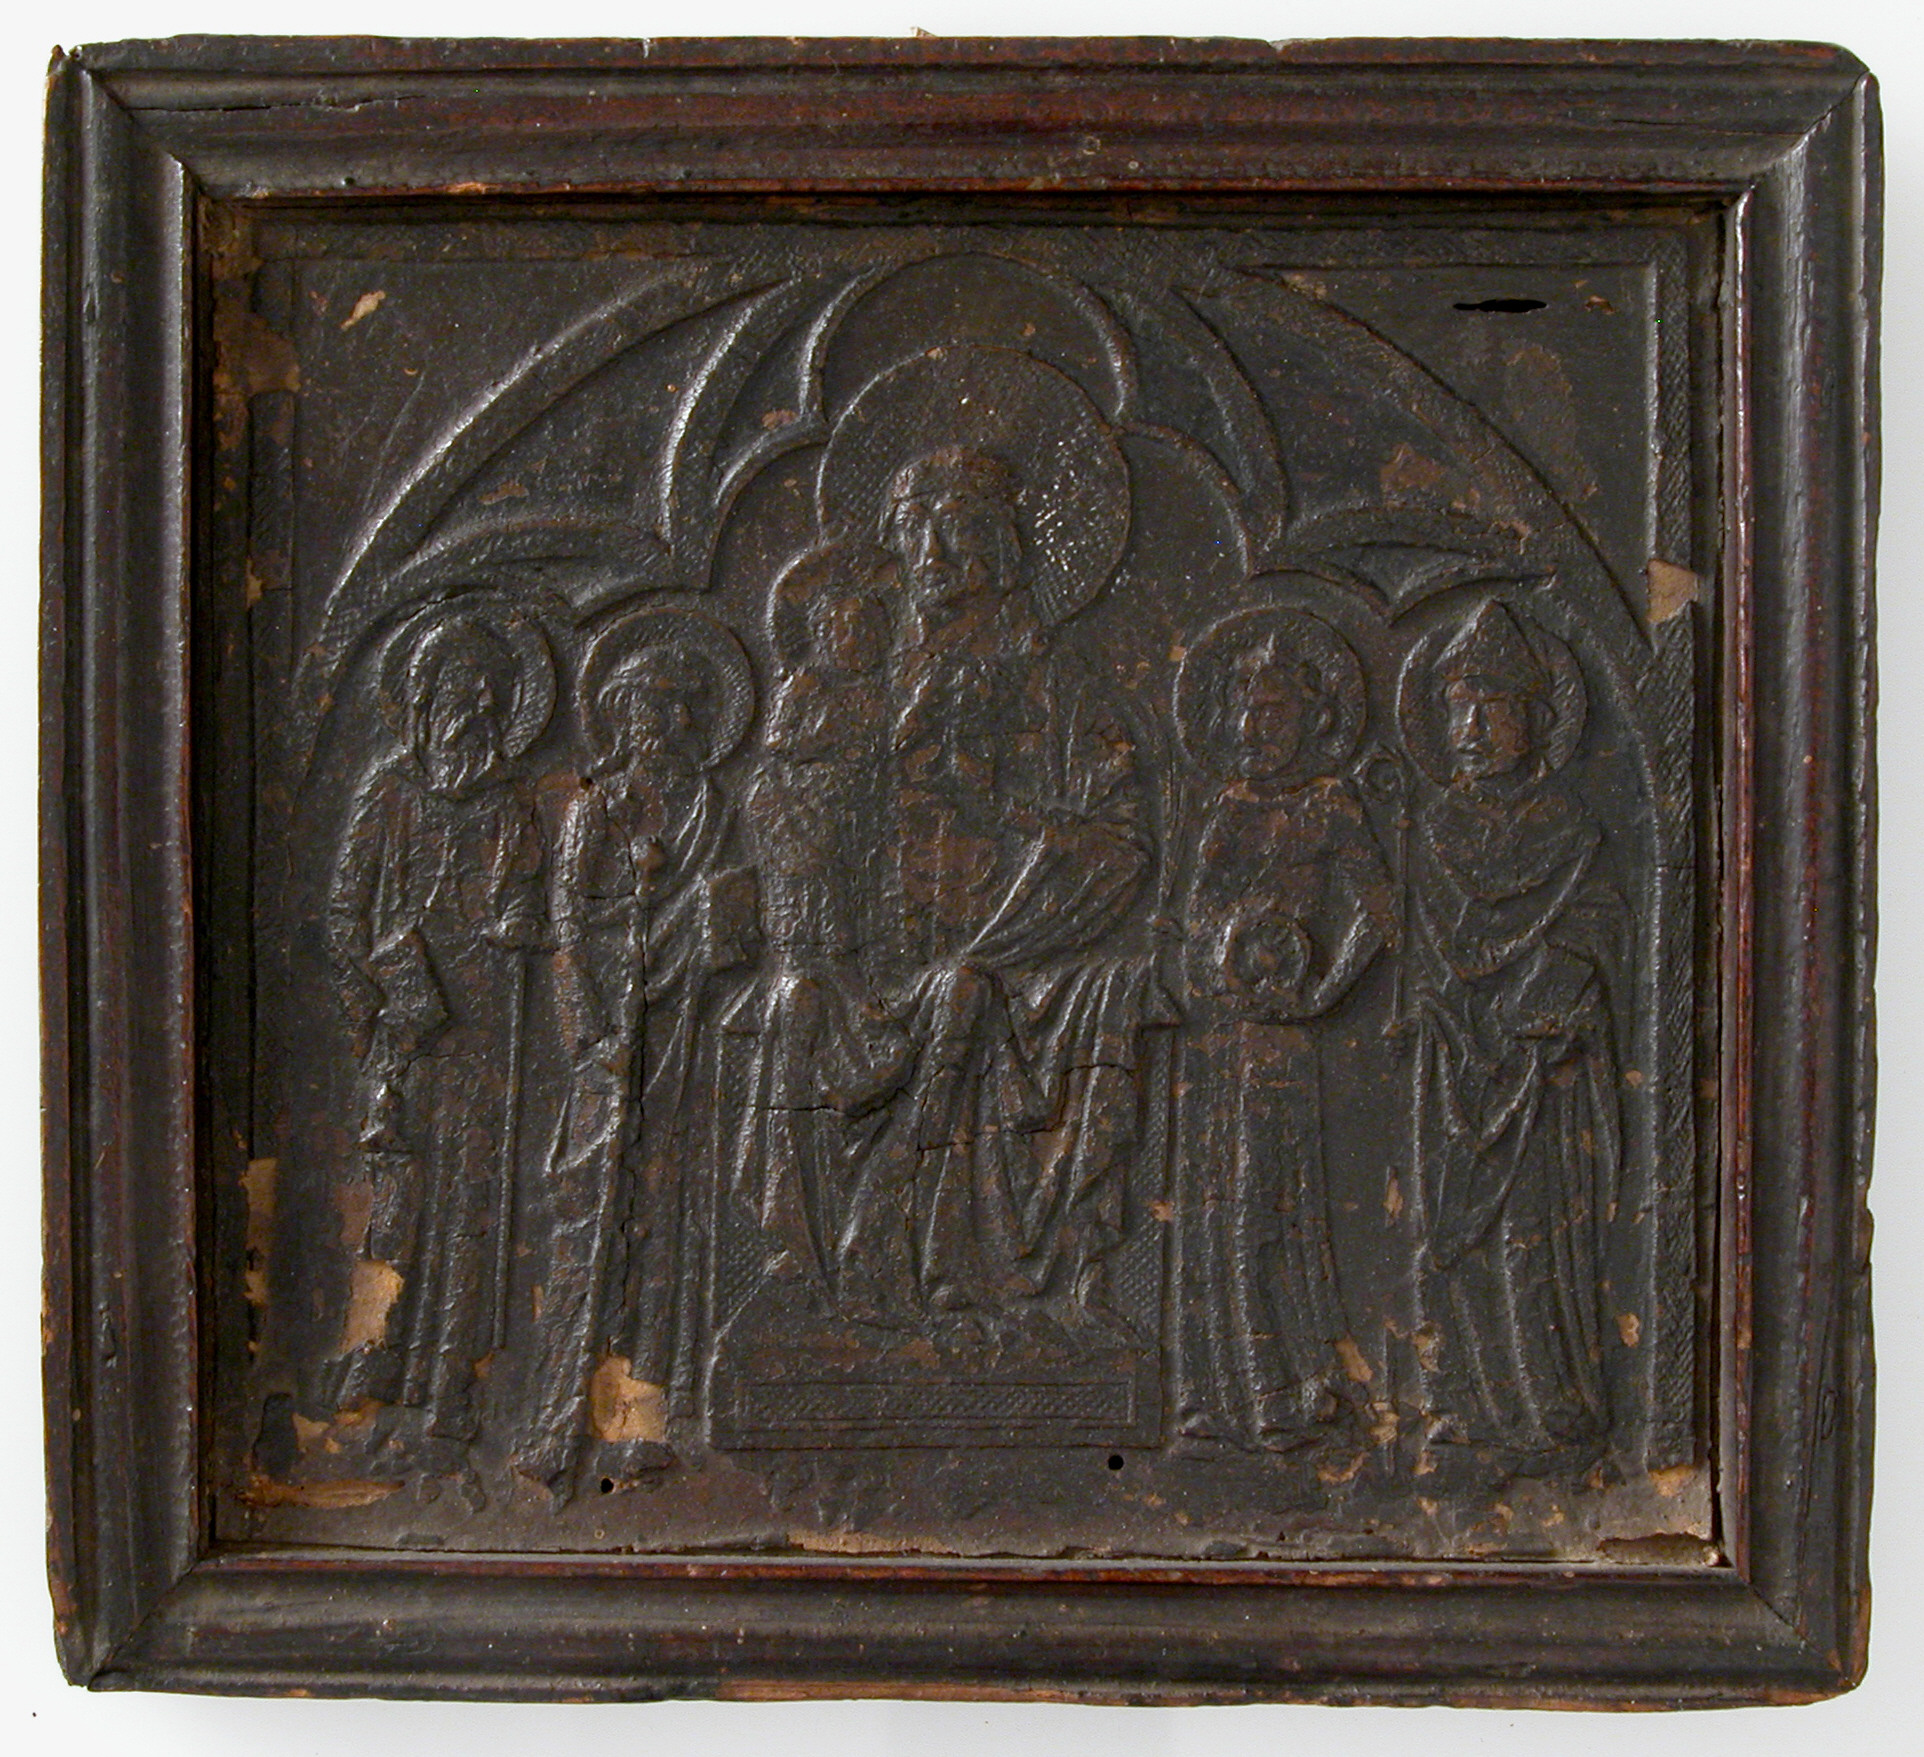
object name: relief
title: Relief of Virgin and Child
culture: italian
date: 1367-1433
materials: leather, paste, wood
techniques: relief, tooling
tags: men